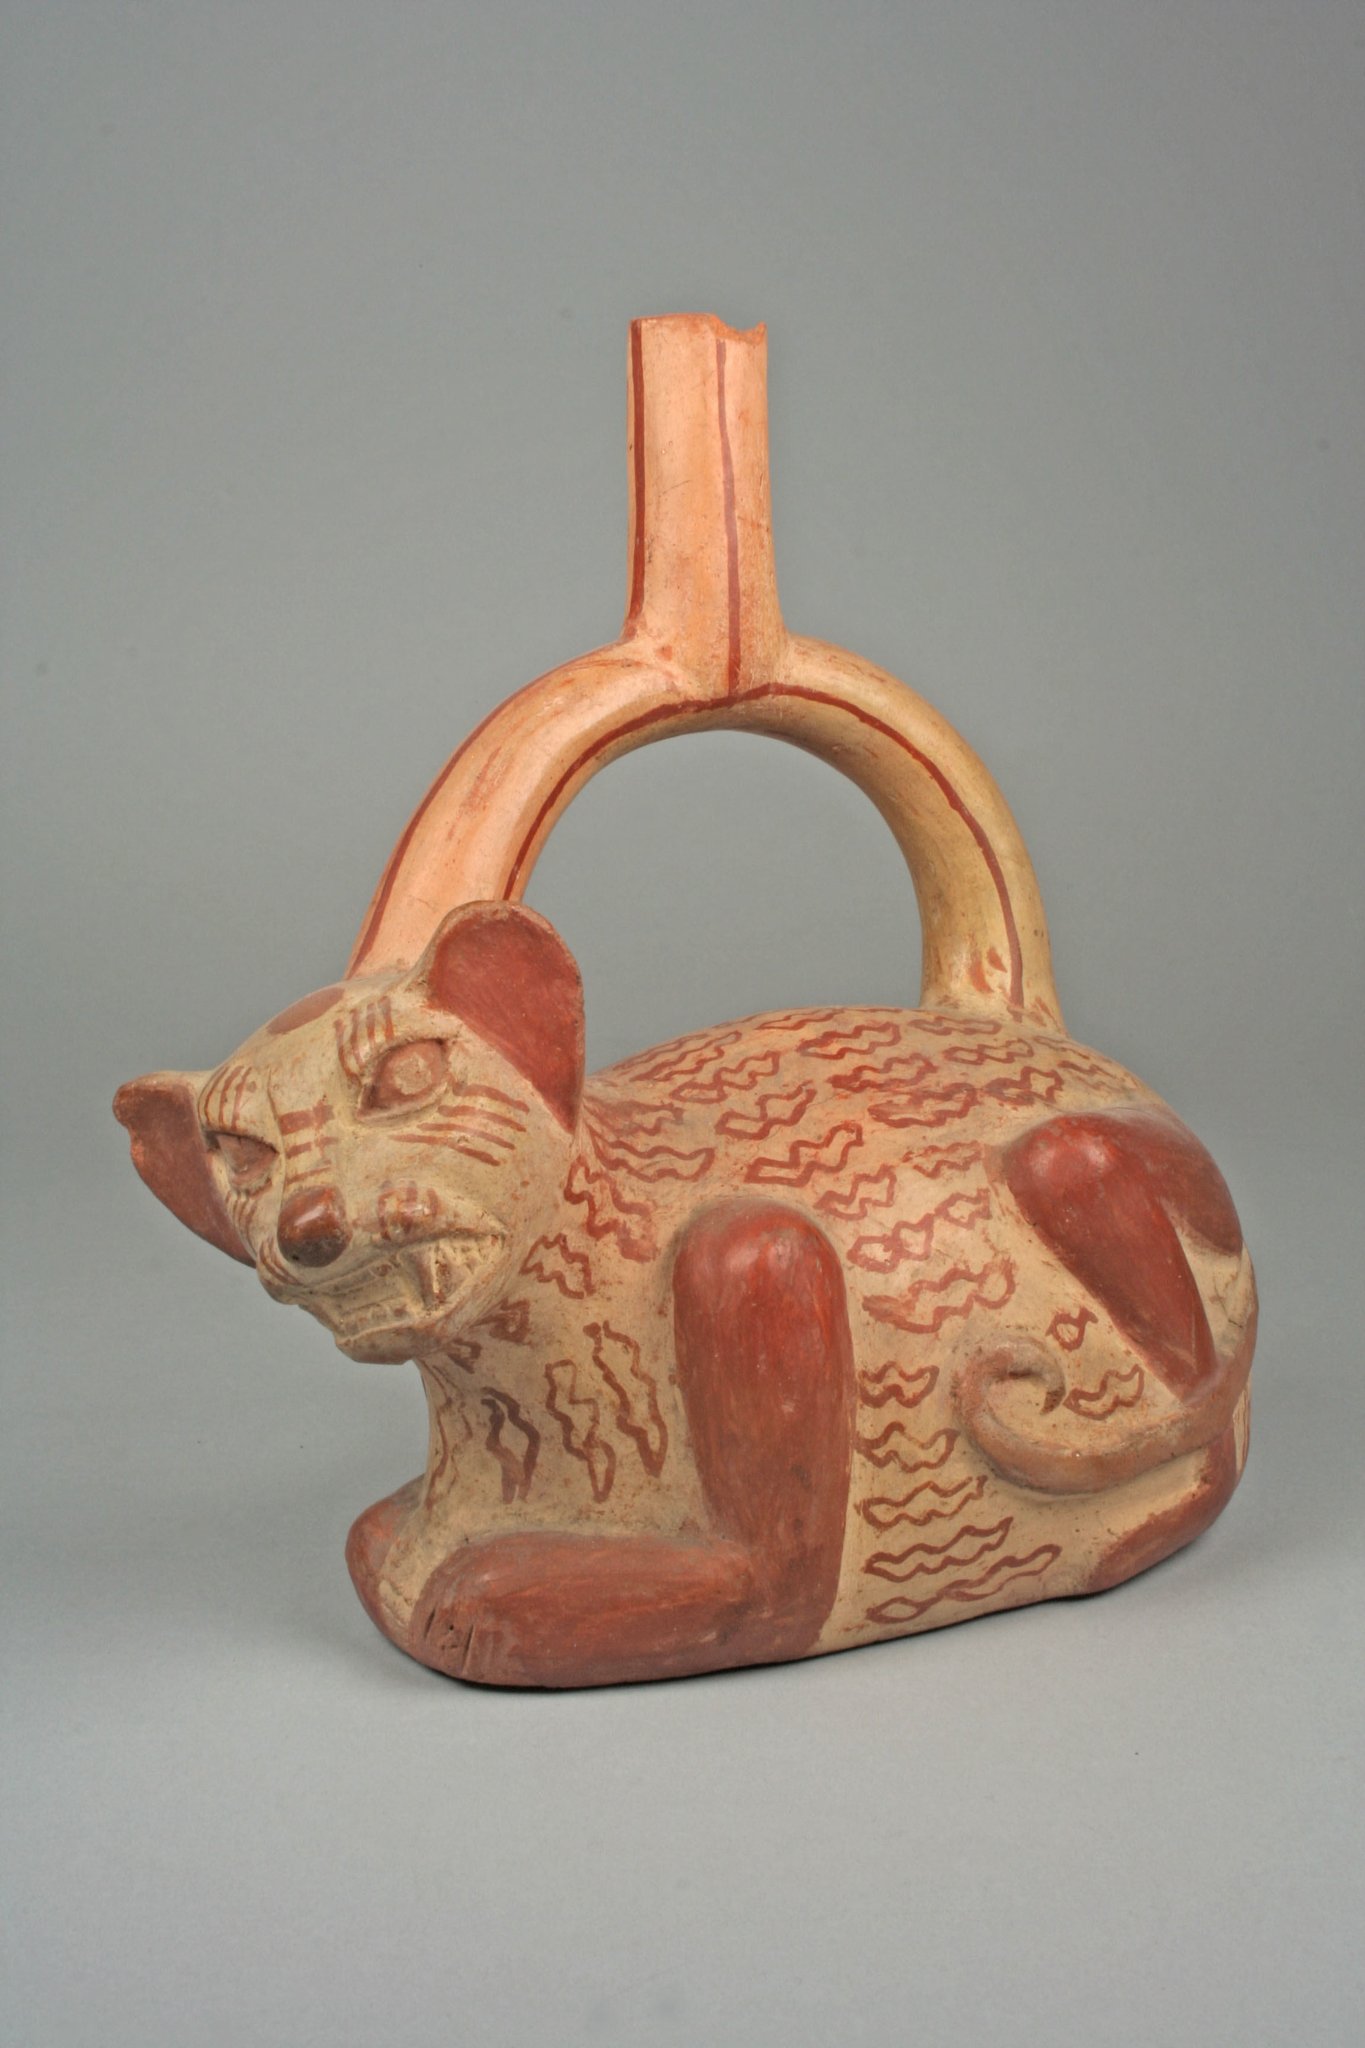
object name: bottle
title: Snarling Feline Bottle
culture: moche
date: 301-700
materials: ceramic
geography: peru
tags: dogs